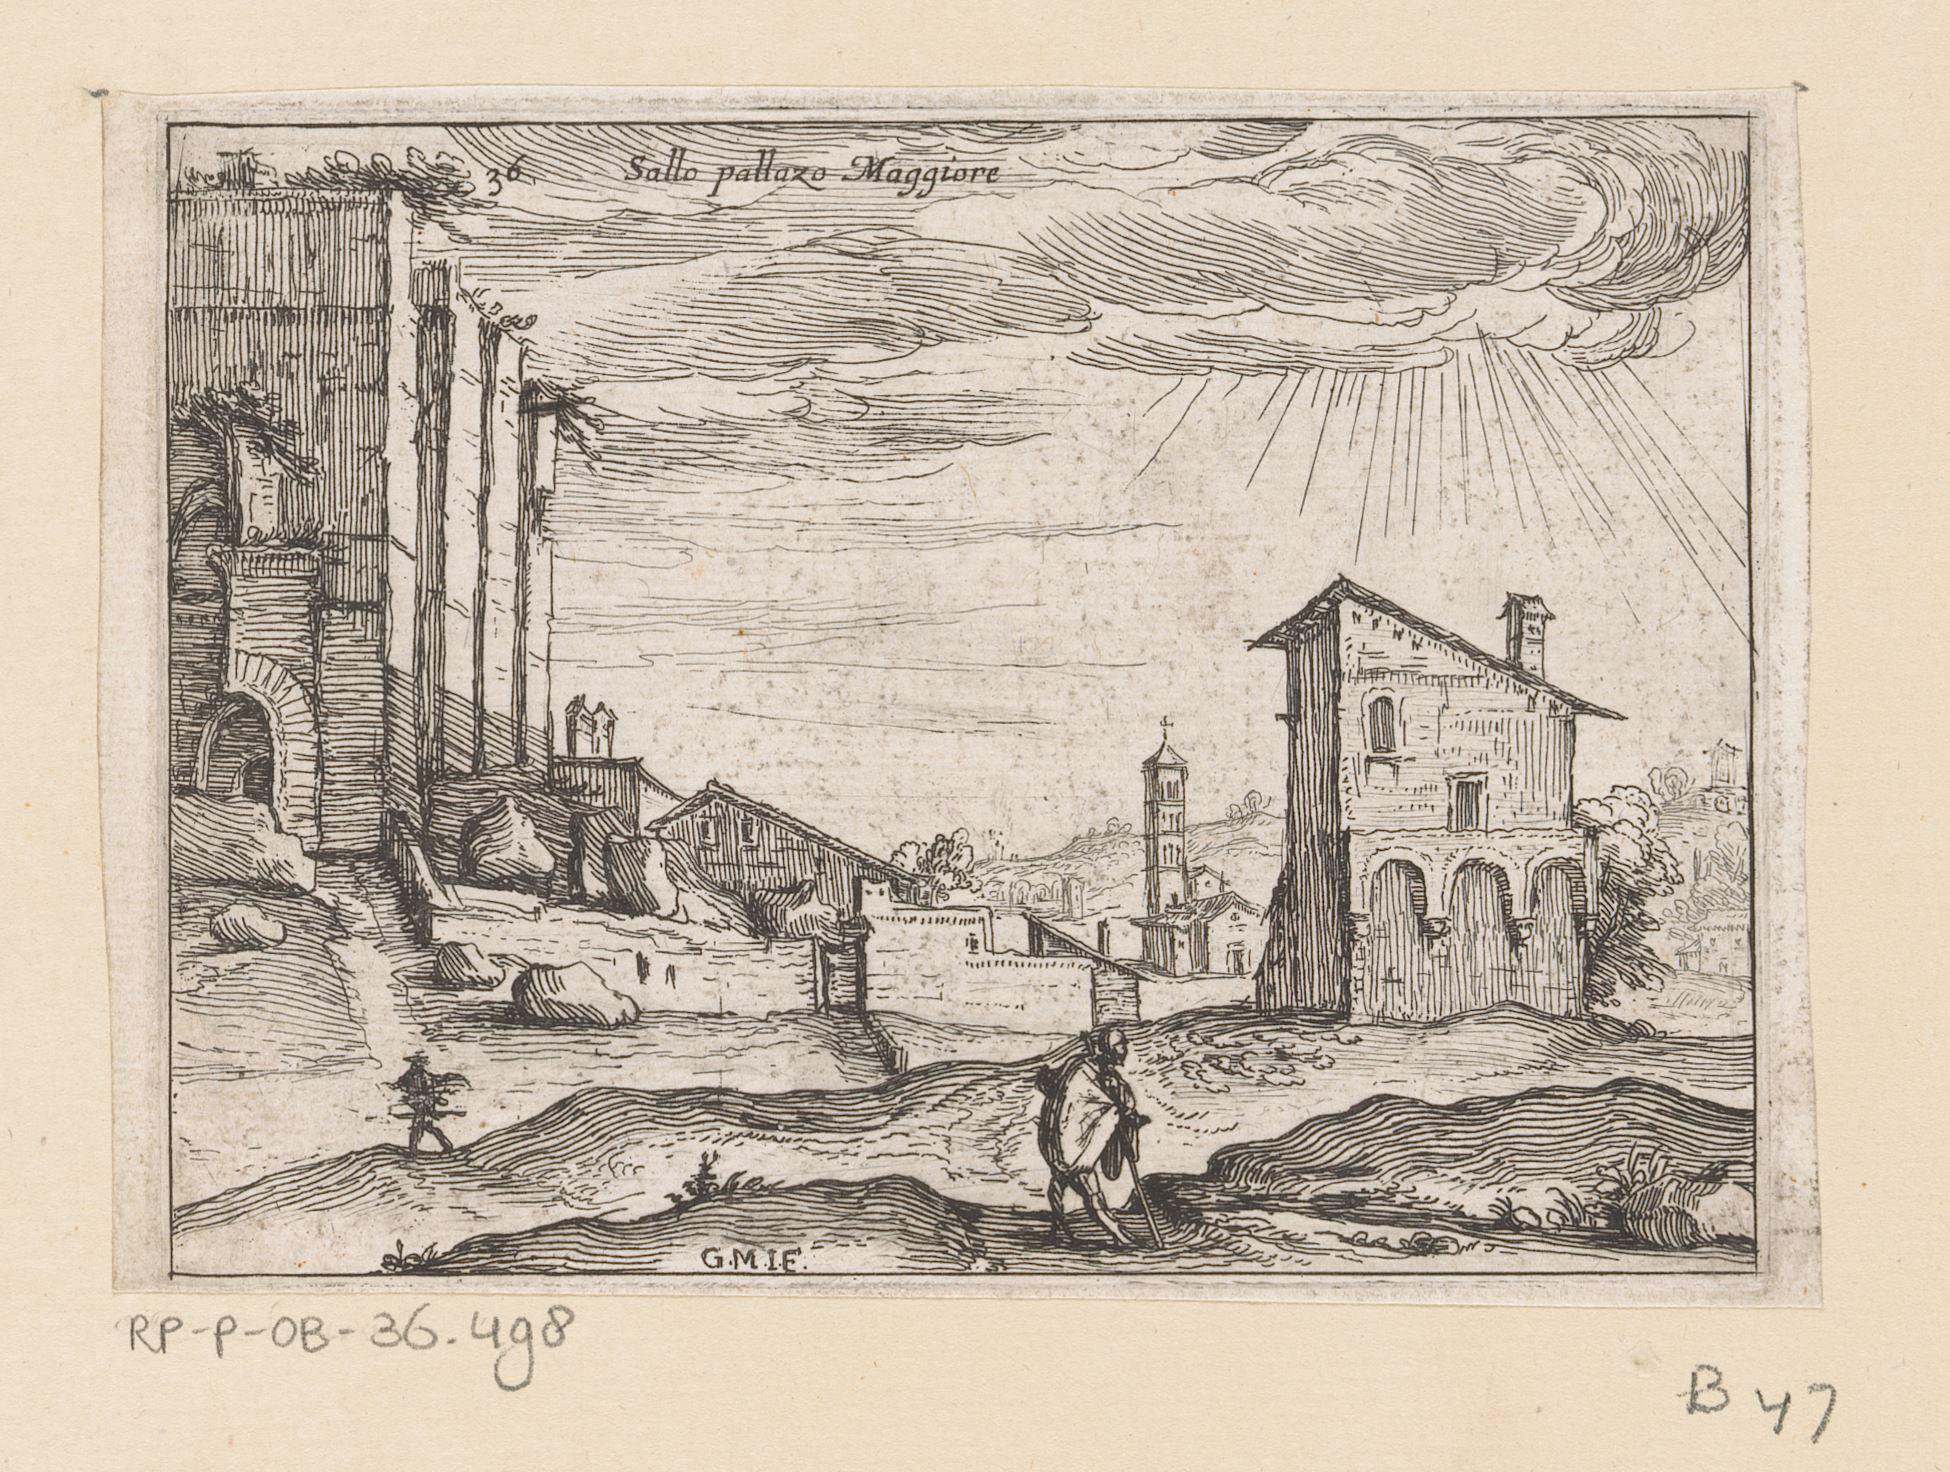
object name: print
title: Alcune vedute et prospettive di luoghi dishabitati di Roma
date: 1629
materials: paper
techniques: etching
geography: italy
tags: landscape with ruins, rome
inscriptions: collector's mark: Lugt 2228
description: Deze prent maakt deel uit van een reeks van 52 prenten.